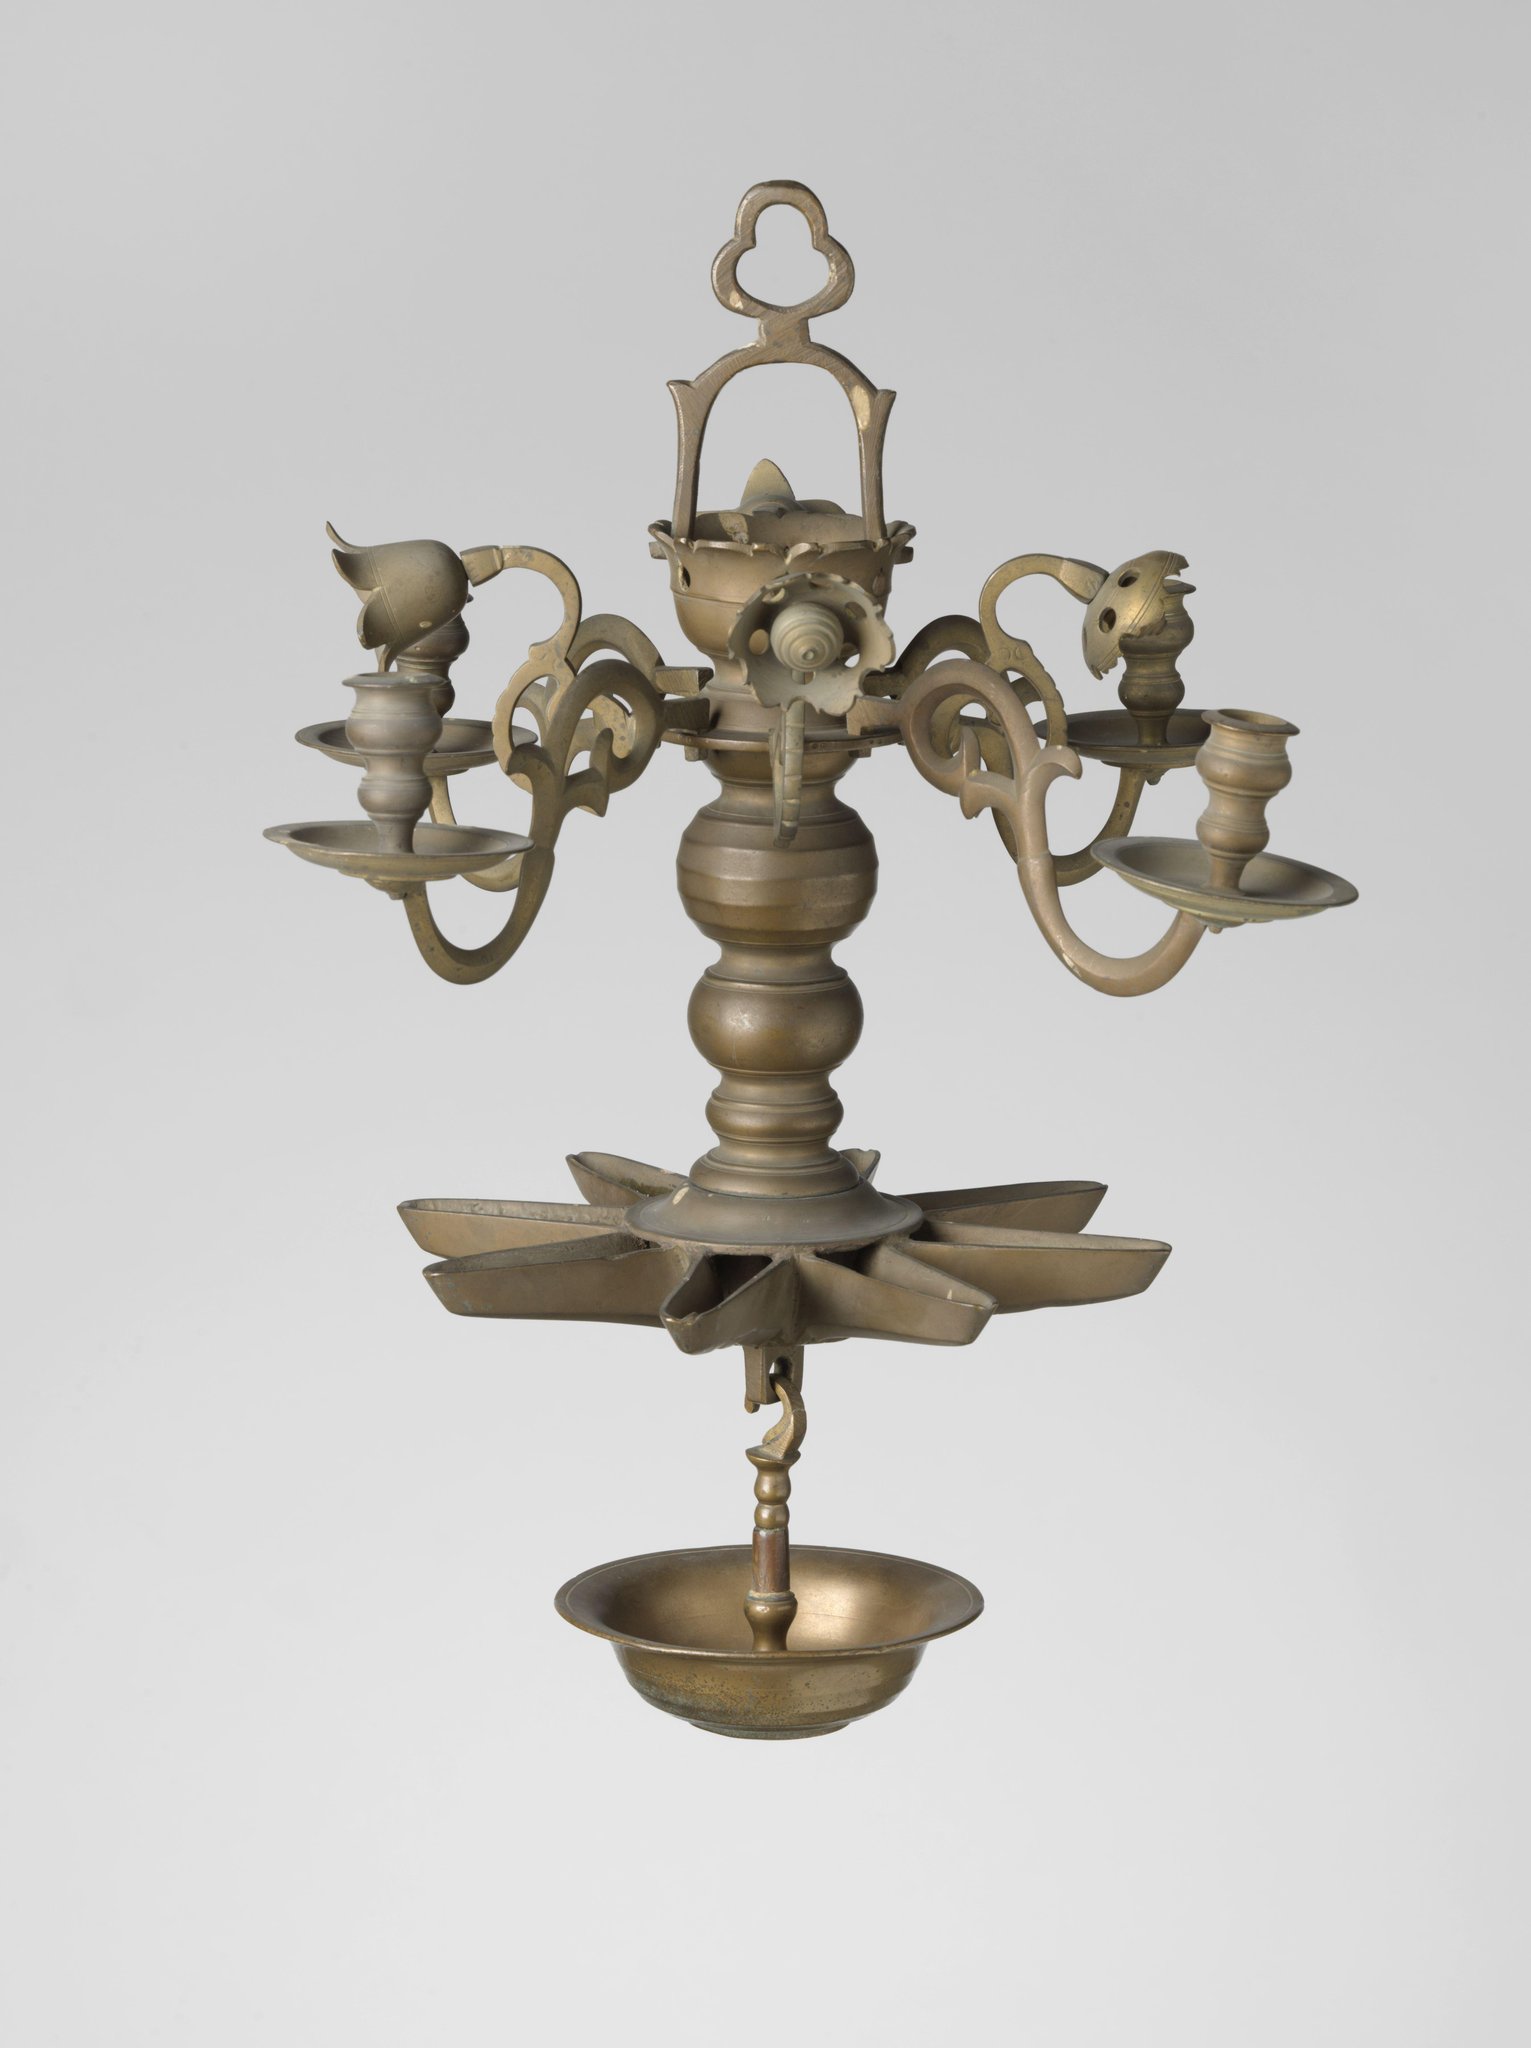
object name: sabbath lamp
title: Arm van sabbathlamp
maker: Anonymous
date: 1700-1800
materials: brass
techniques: casting, screwed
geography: nuremberg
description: Arm van een sabbathlamp. De S-vormige arm eindigt naar de stam toe in een krul en gaat naar buiten toe over in een plat bevestigingsdeel, waarin de bol- en holronde zich naar de voet verjongende houder op de geprofileerde ronde vetvanger is geschroefd. Dit is de vierde arm, ongenummerd.